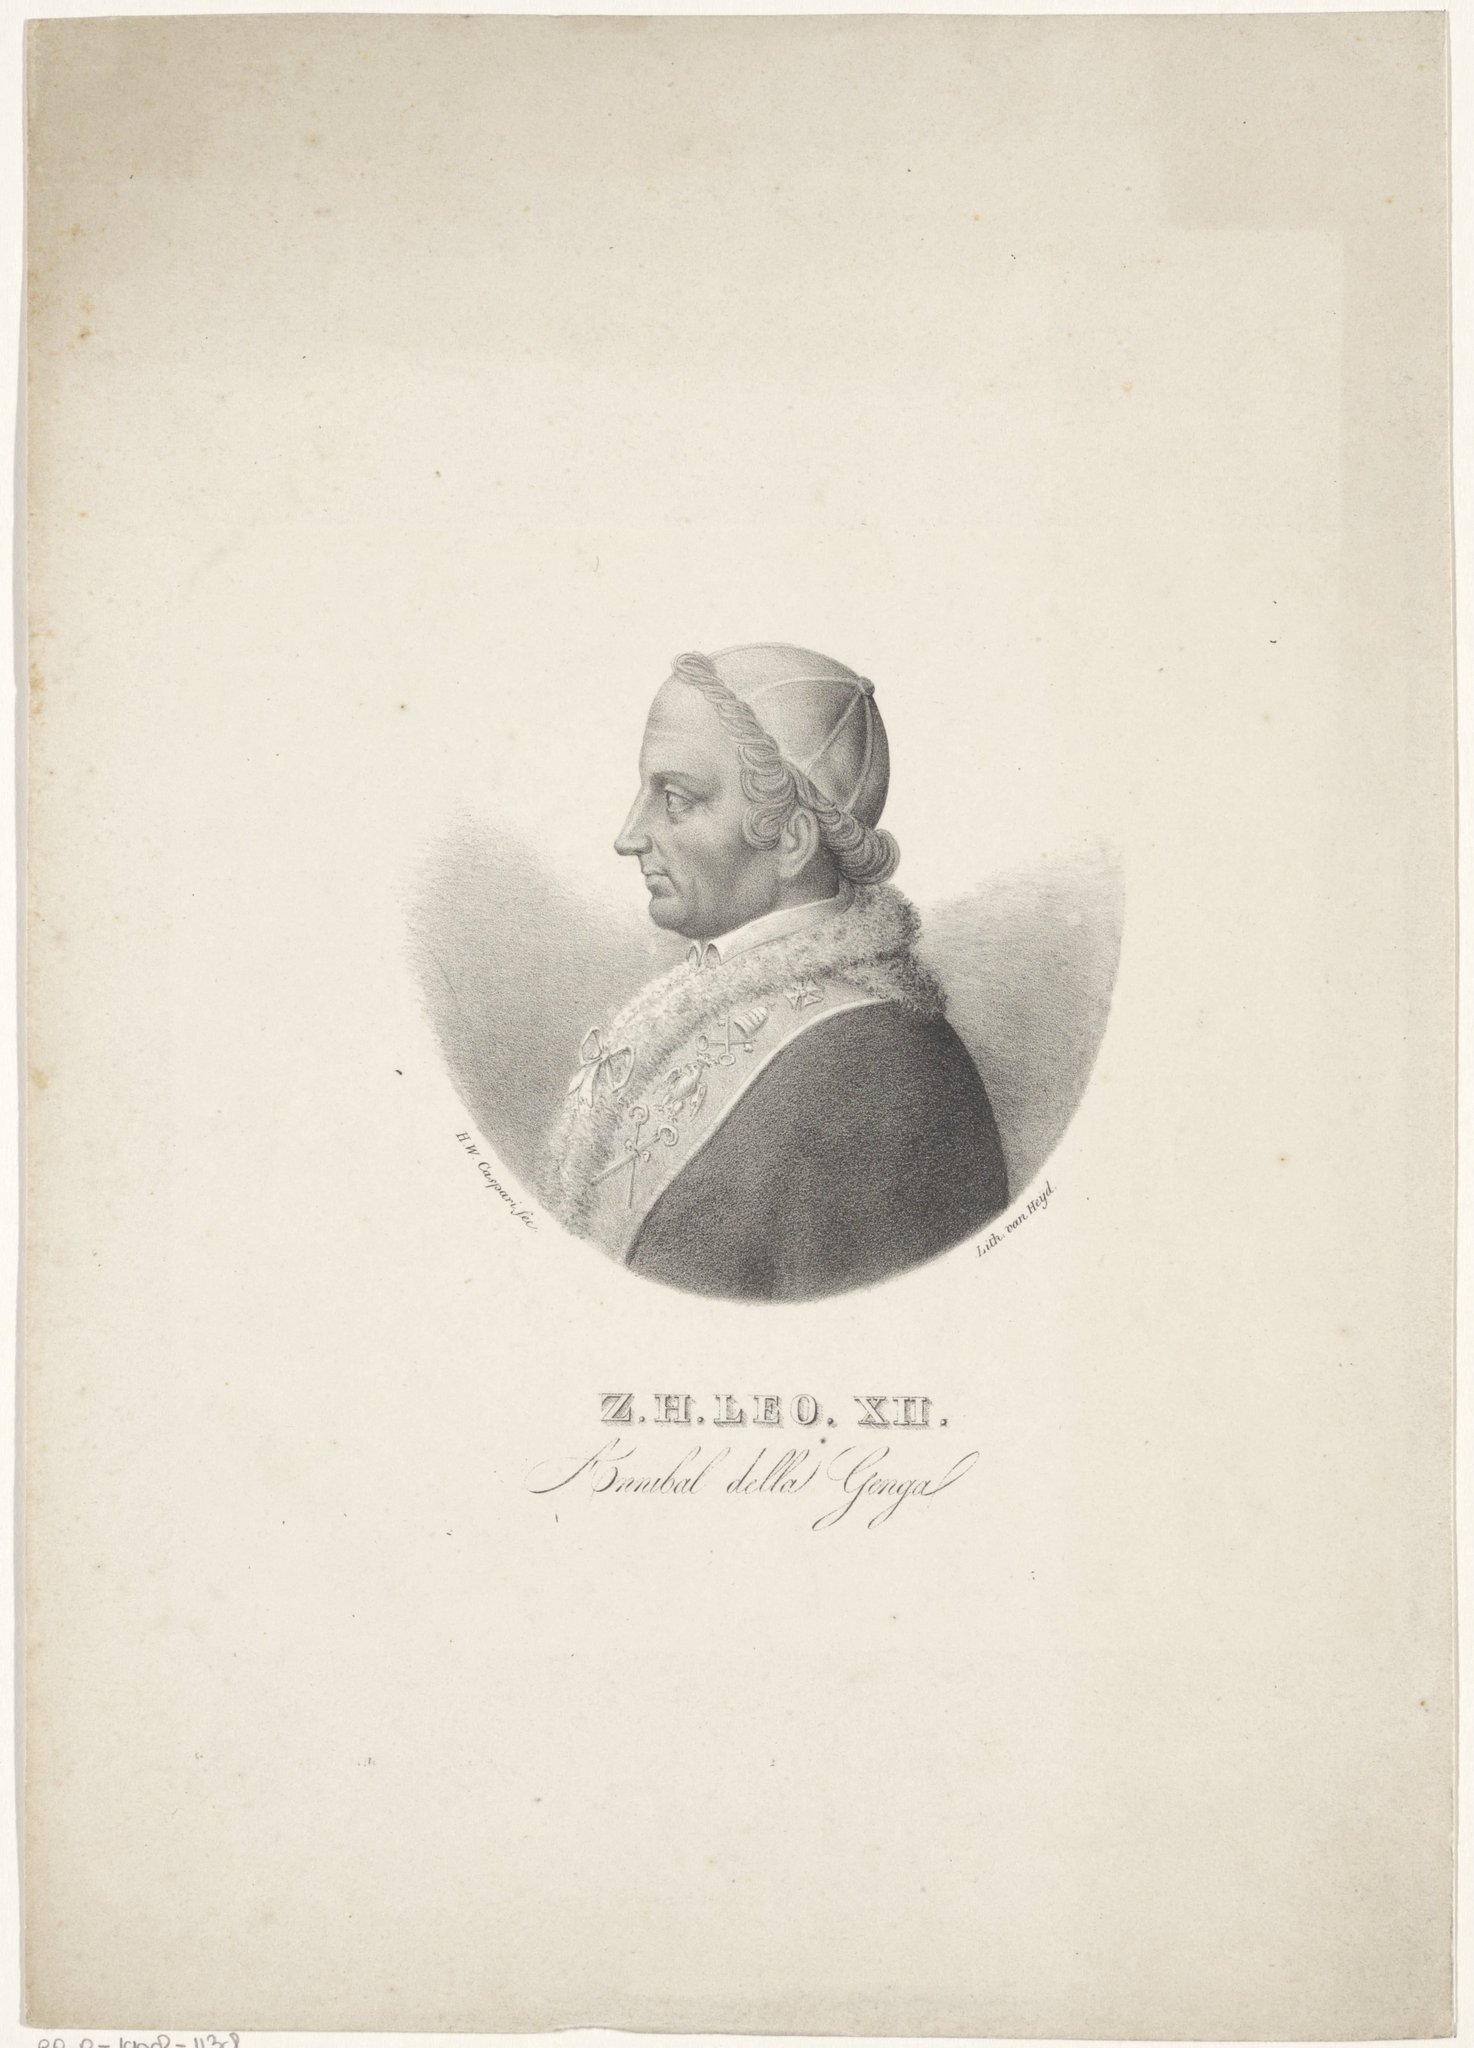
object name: print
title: Portret van paus Leo XII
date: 1809-1829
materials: paper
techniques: lithograph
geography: amsterdam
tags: rome, historical persons (+ profile portrait)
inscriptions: collector's mark: Lugt 2228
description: De geportretteerde is en profil afgebeeld en kijkt naar links. Om zijn hals draagt hij een bontkraag en een gedecoreerde stola.